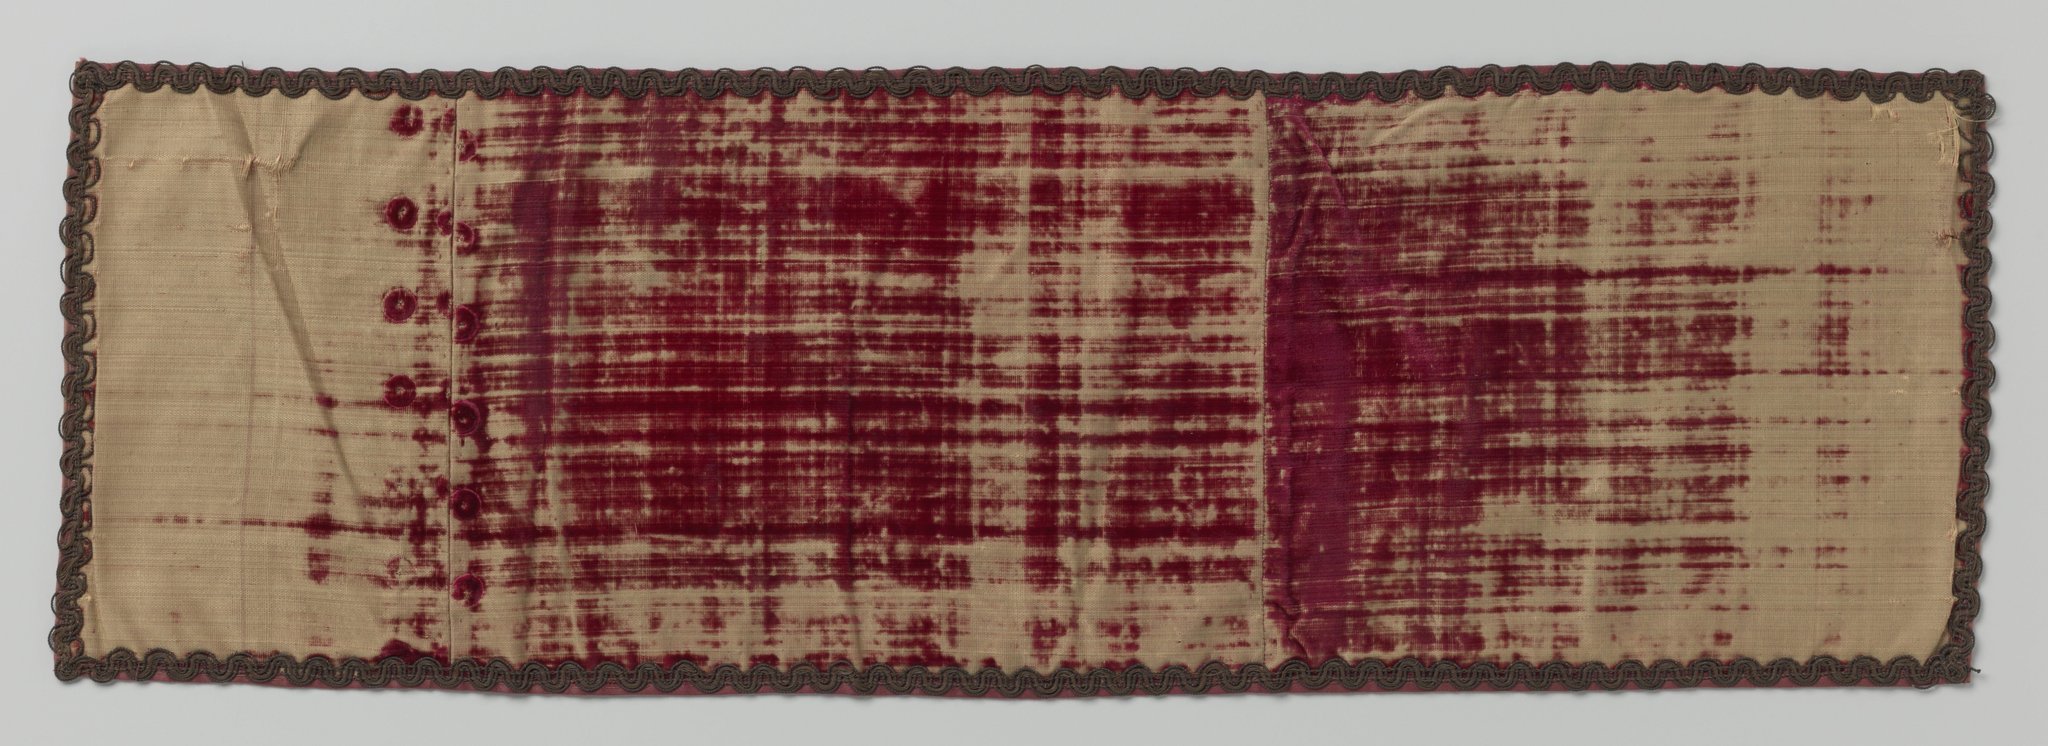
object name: kleed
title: Kleed van rood zijden fluweel.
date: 1600-1699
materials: cotton, textile, silk, velvet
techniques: weave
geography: italy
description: Kleed van rood zijden fluweel. Het kleed bestaat uit drie fragmenten. Het kleed is omzoomd door een bruin getint goudgalon. Het kleed is gevoerd met rode satijn.